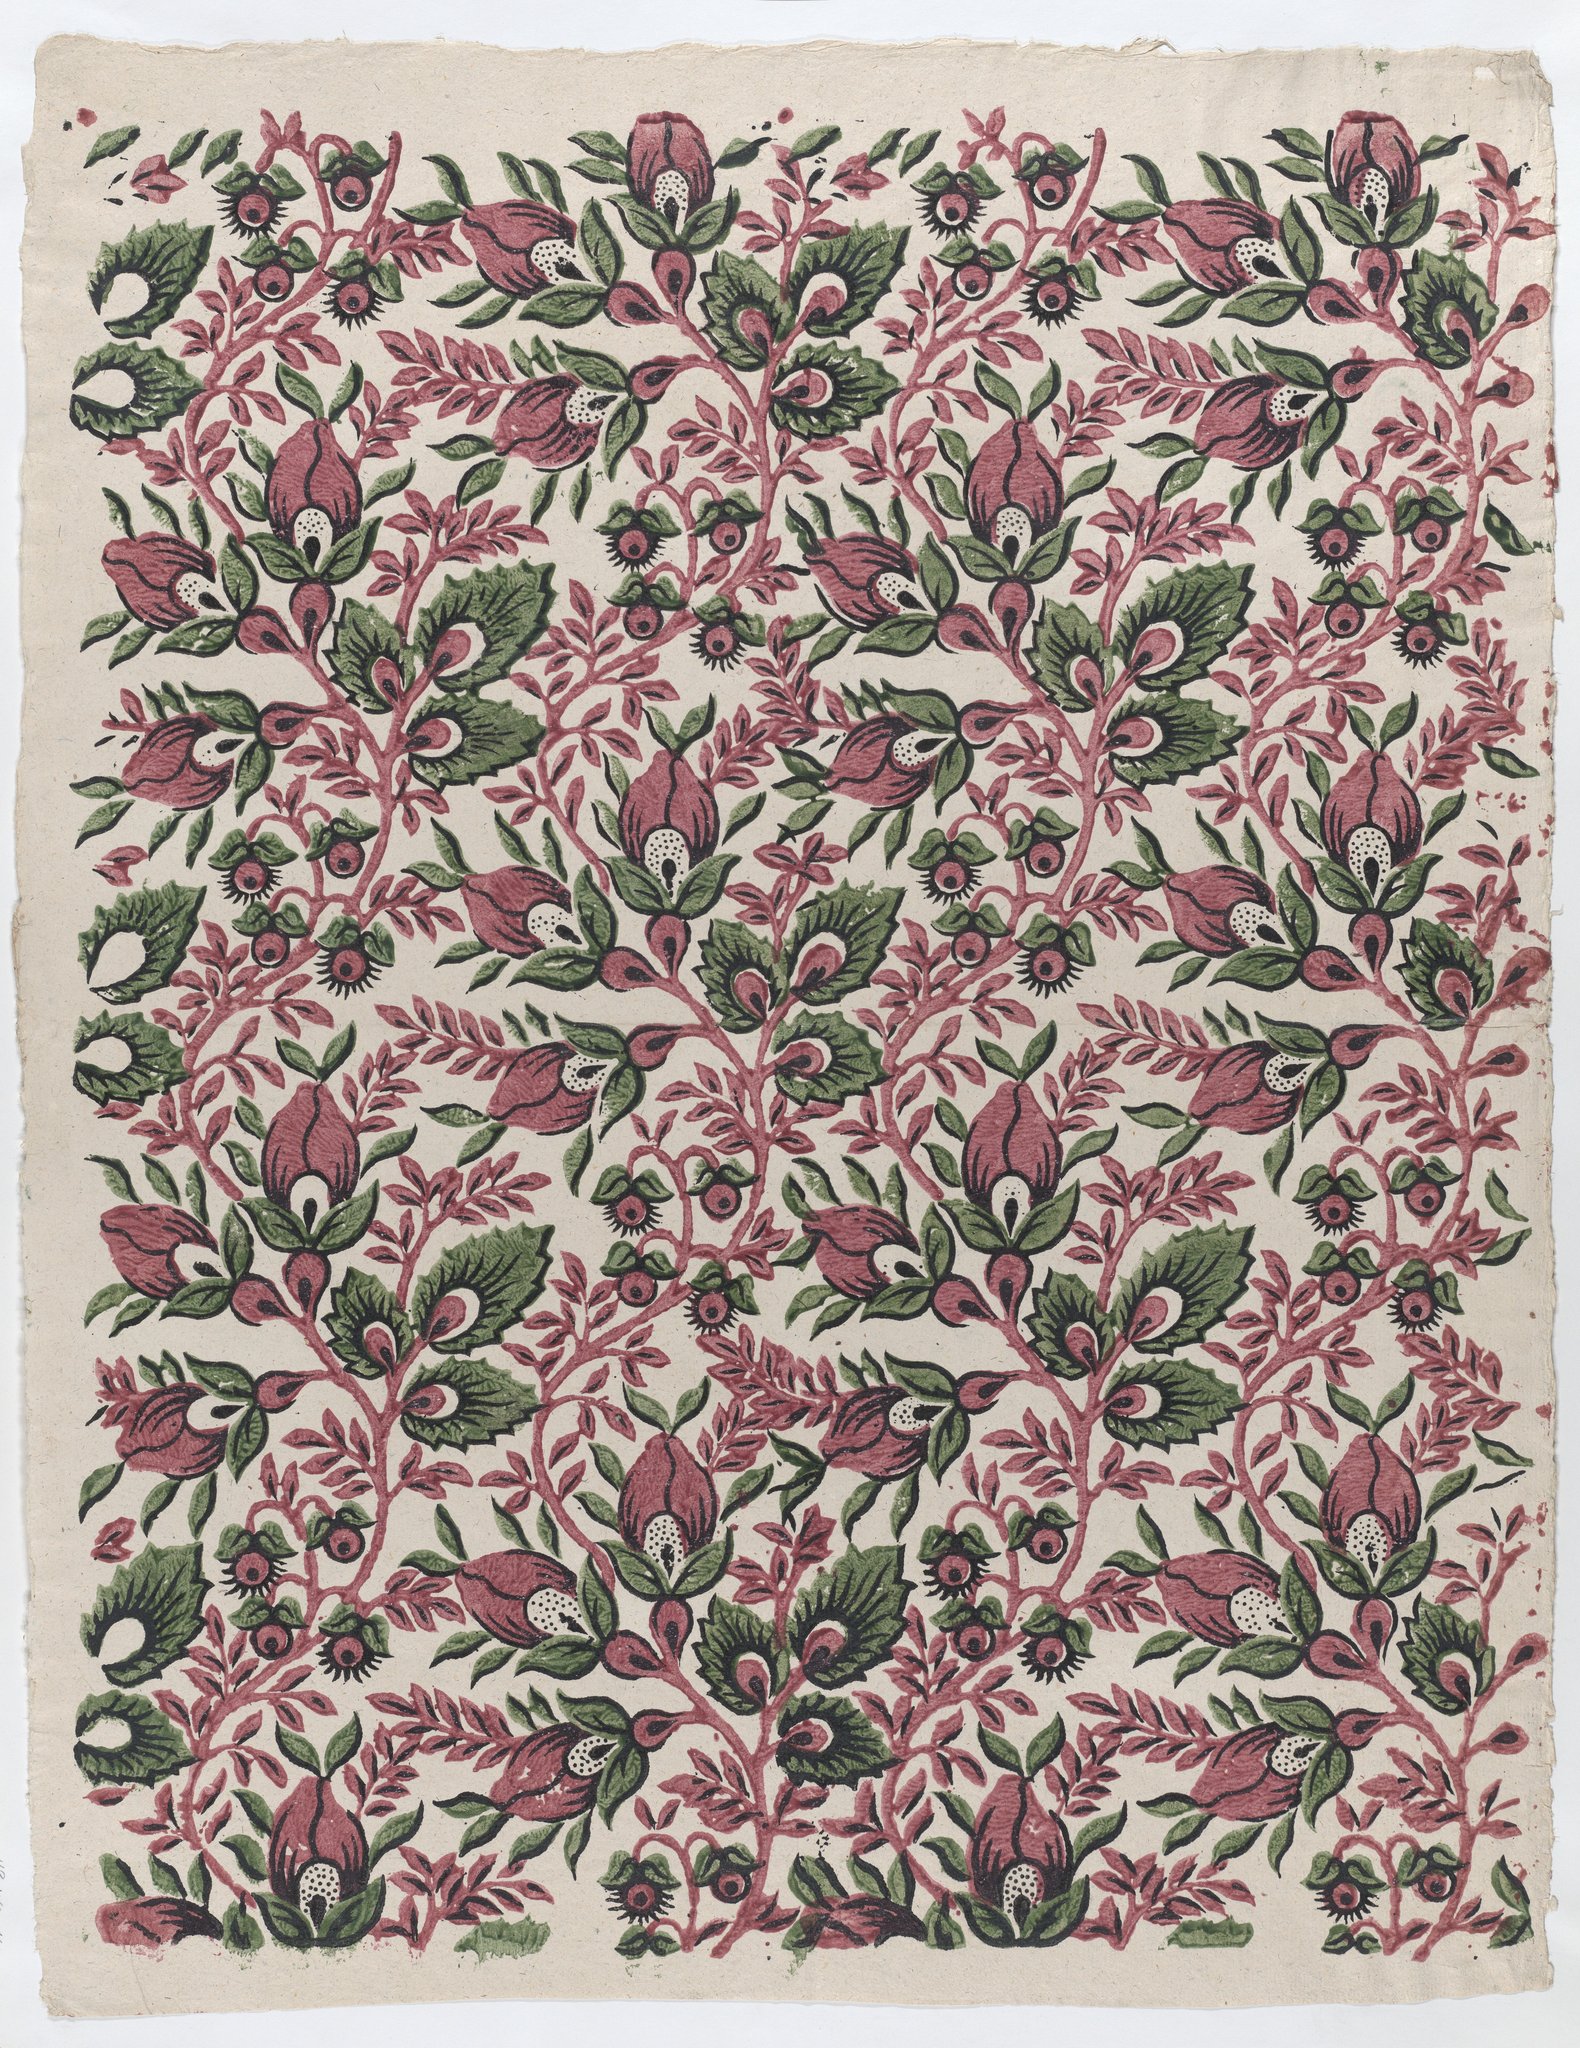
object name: print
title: Sheet with overall floral and vine pattern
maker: Anonymous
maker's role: artist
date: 1767-1866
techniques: relief print